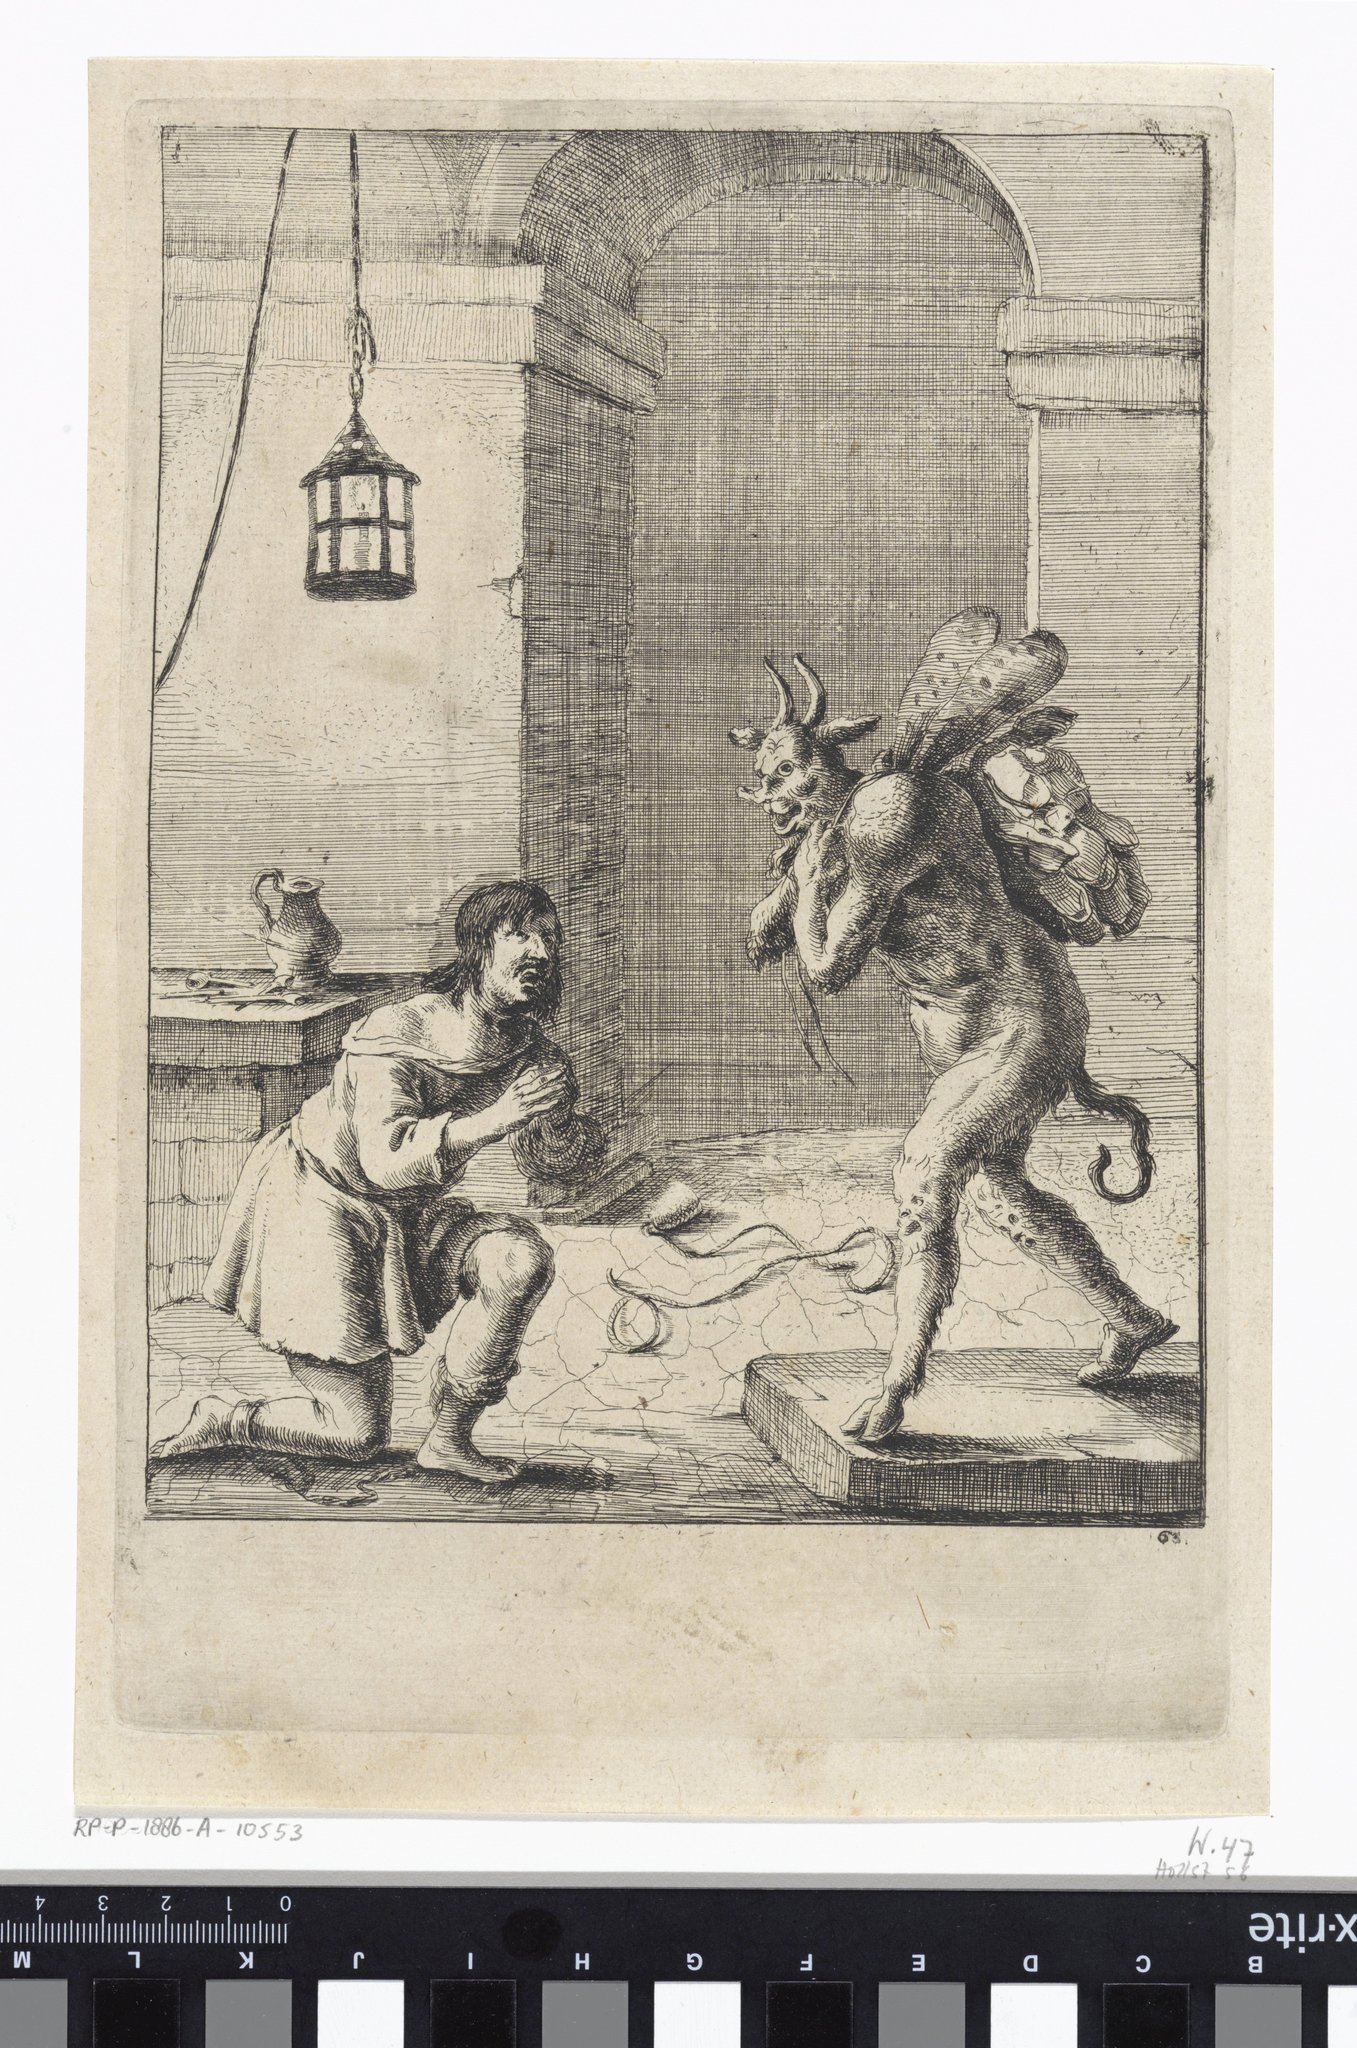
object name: book illustration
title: Fabel van de duivel en de misdadiger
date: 1665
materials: paper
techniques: etching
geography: london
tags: devil(s) and demons, prisoner; in fetters, fables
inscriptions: collector's mark: Lugt 2228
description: De duivel wordt aangeroepen door een misdadiger, die in de gevangenis zit. De duivel draagt een bundel oude schoenen op zijn rug. Illustratie van een fabel van Aesopus.